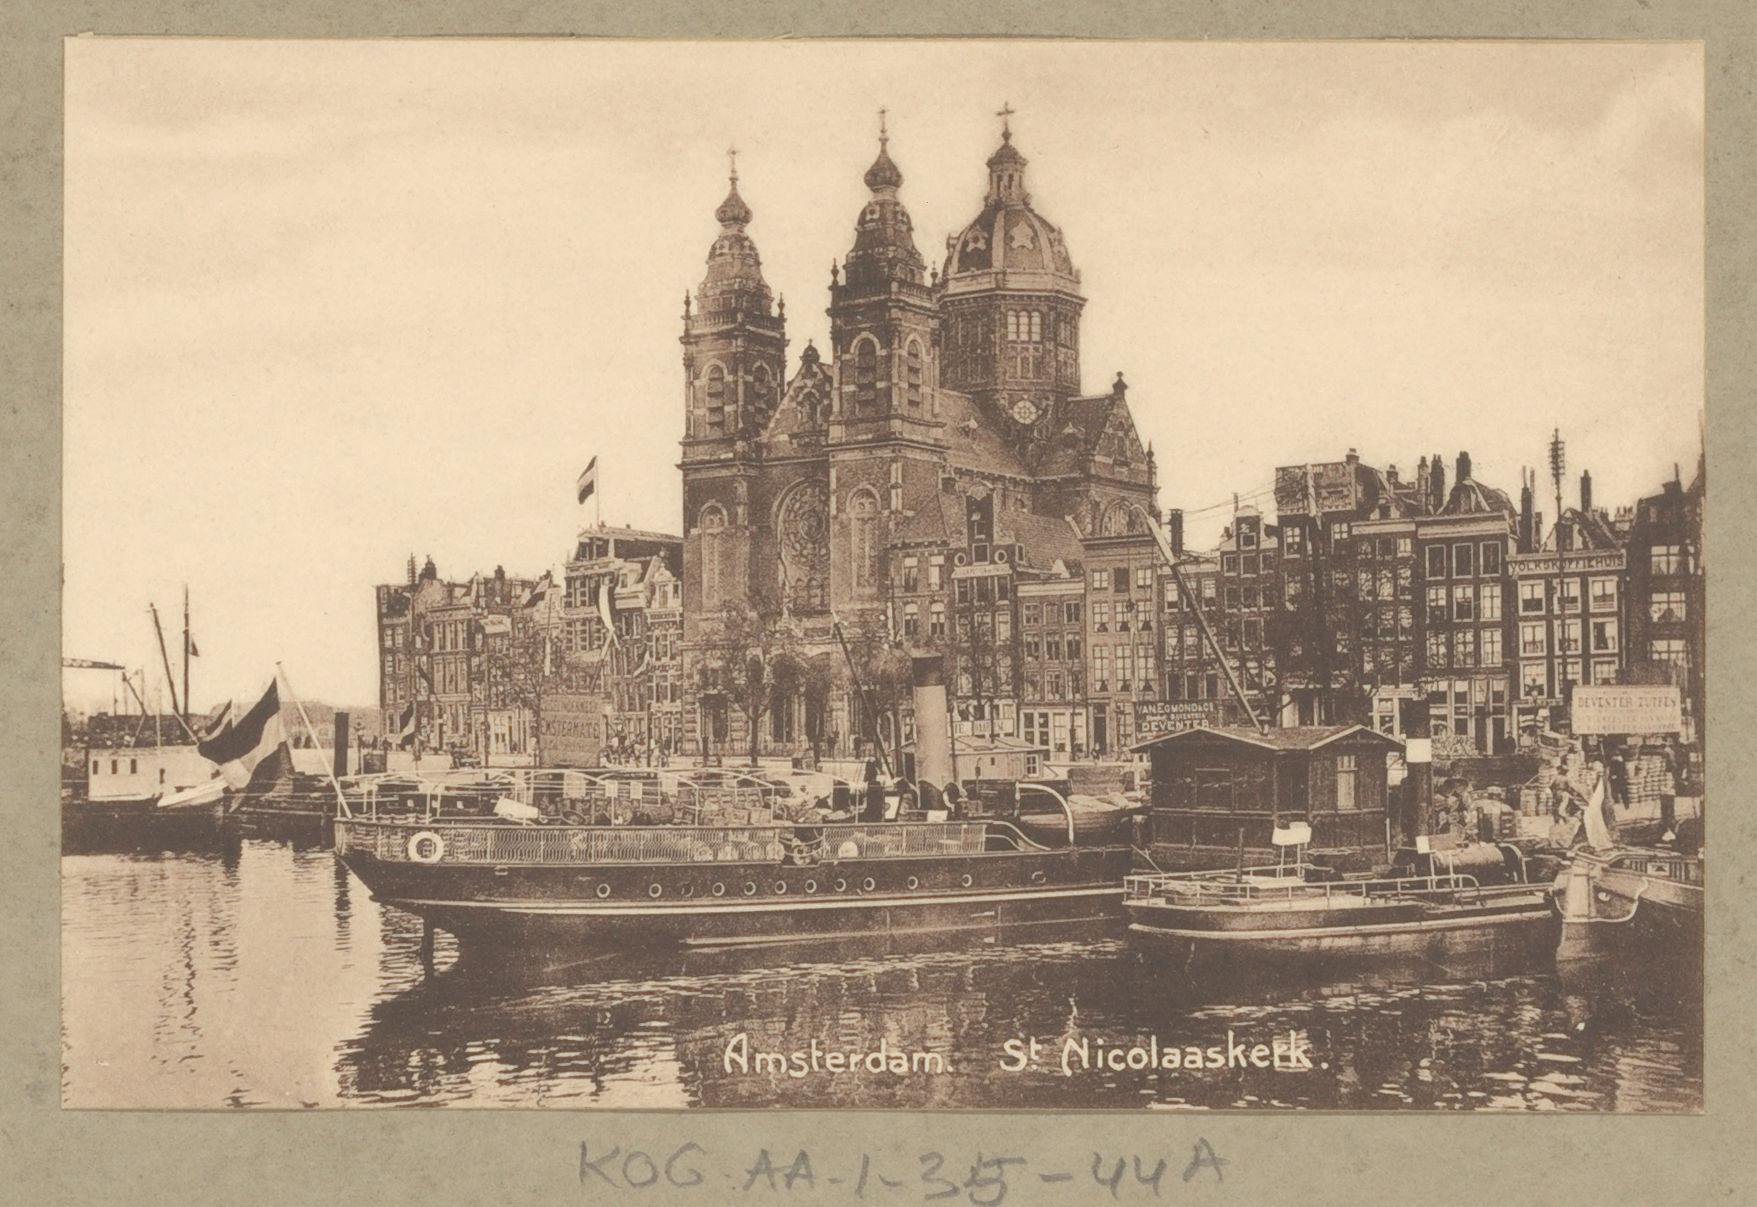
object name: ansichtkaart, prentbriefkaart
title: Gezicht op de Basiliek van de Heilige Nicolaas te Amsterdam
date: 1887-1908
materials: cardboard, paper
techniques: photograph, letterpress printing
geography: amsterdam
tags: harbour, city-view in general; 'veduta', roman catholic church, parts of church exterior and annexes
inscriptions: collector's mark: ‘35-44’ Lugt 1641b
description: Onderwerpsrubriek binnen de Atlas Amsterdam: R.K. Gemeenten: Sint Nicolaaskerk t/m Willibrordus (Rustenburgerstraat).